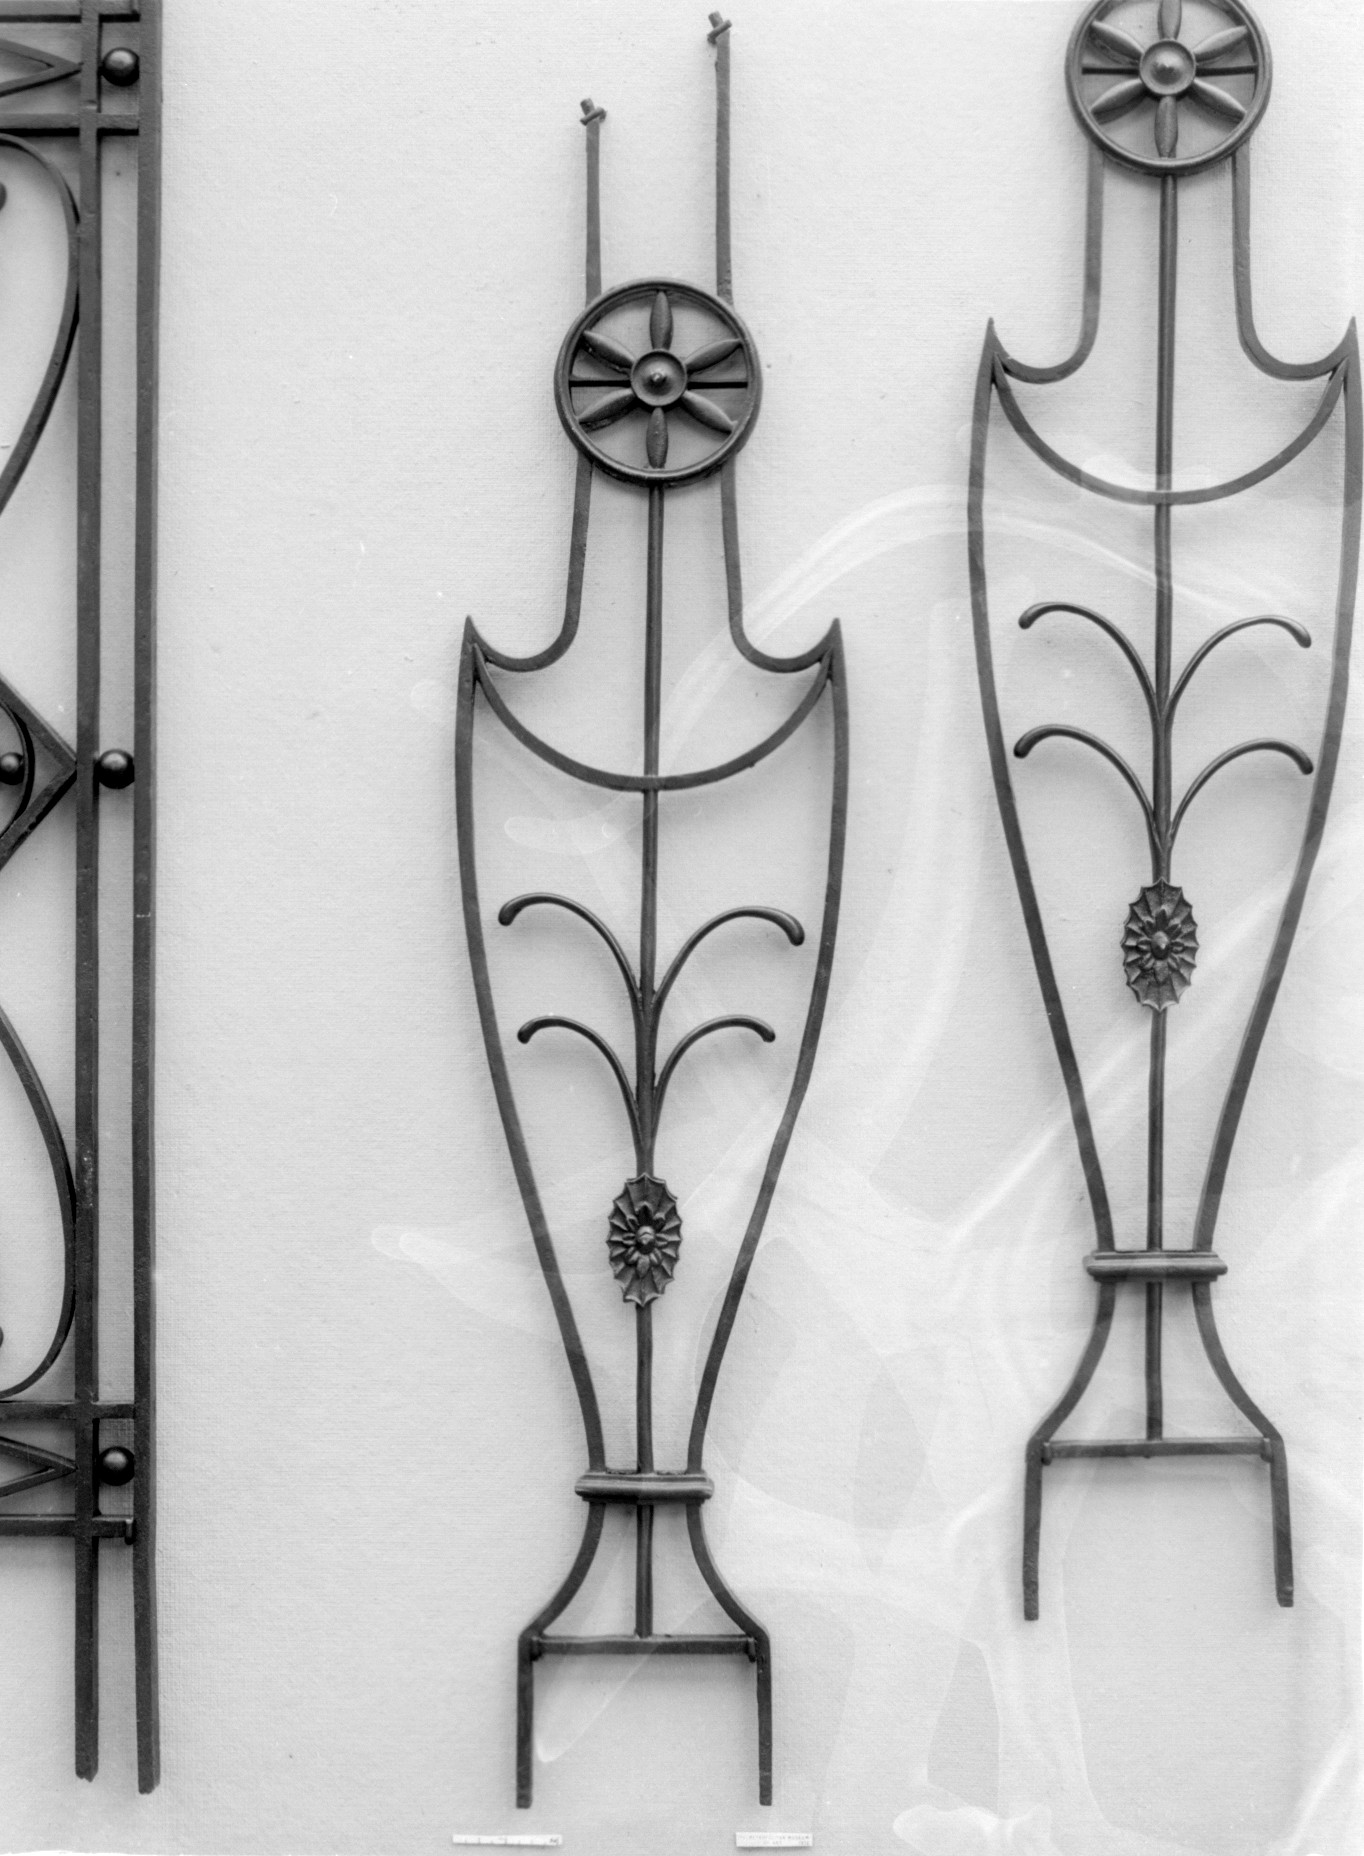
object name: baluster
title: Baluster (one of pair)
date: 1701-1800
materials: brass, iron